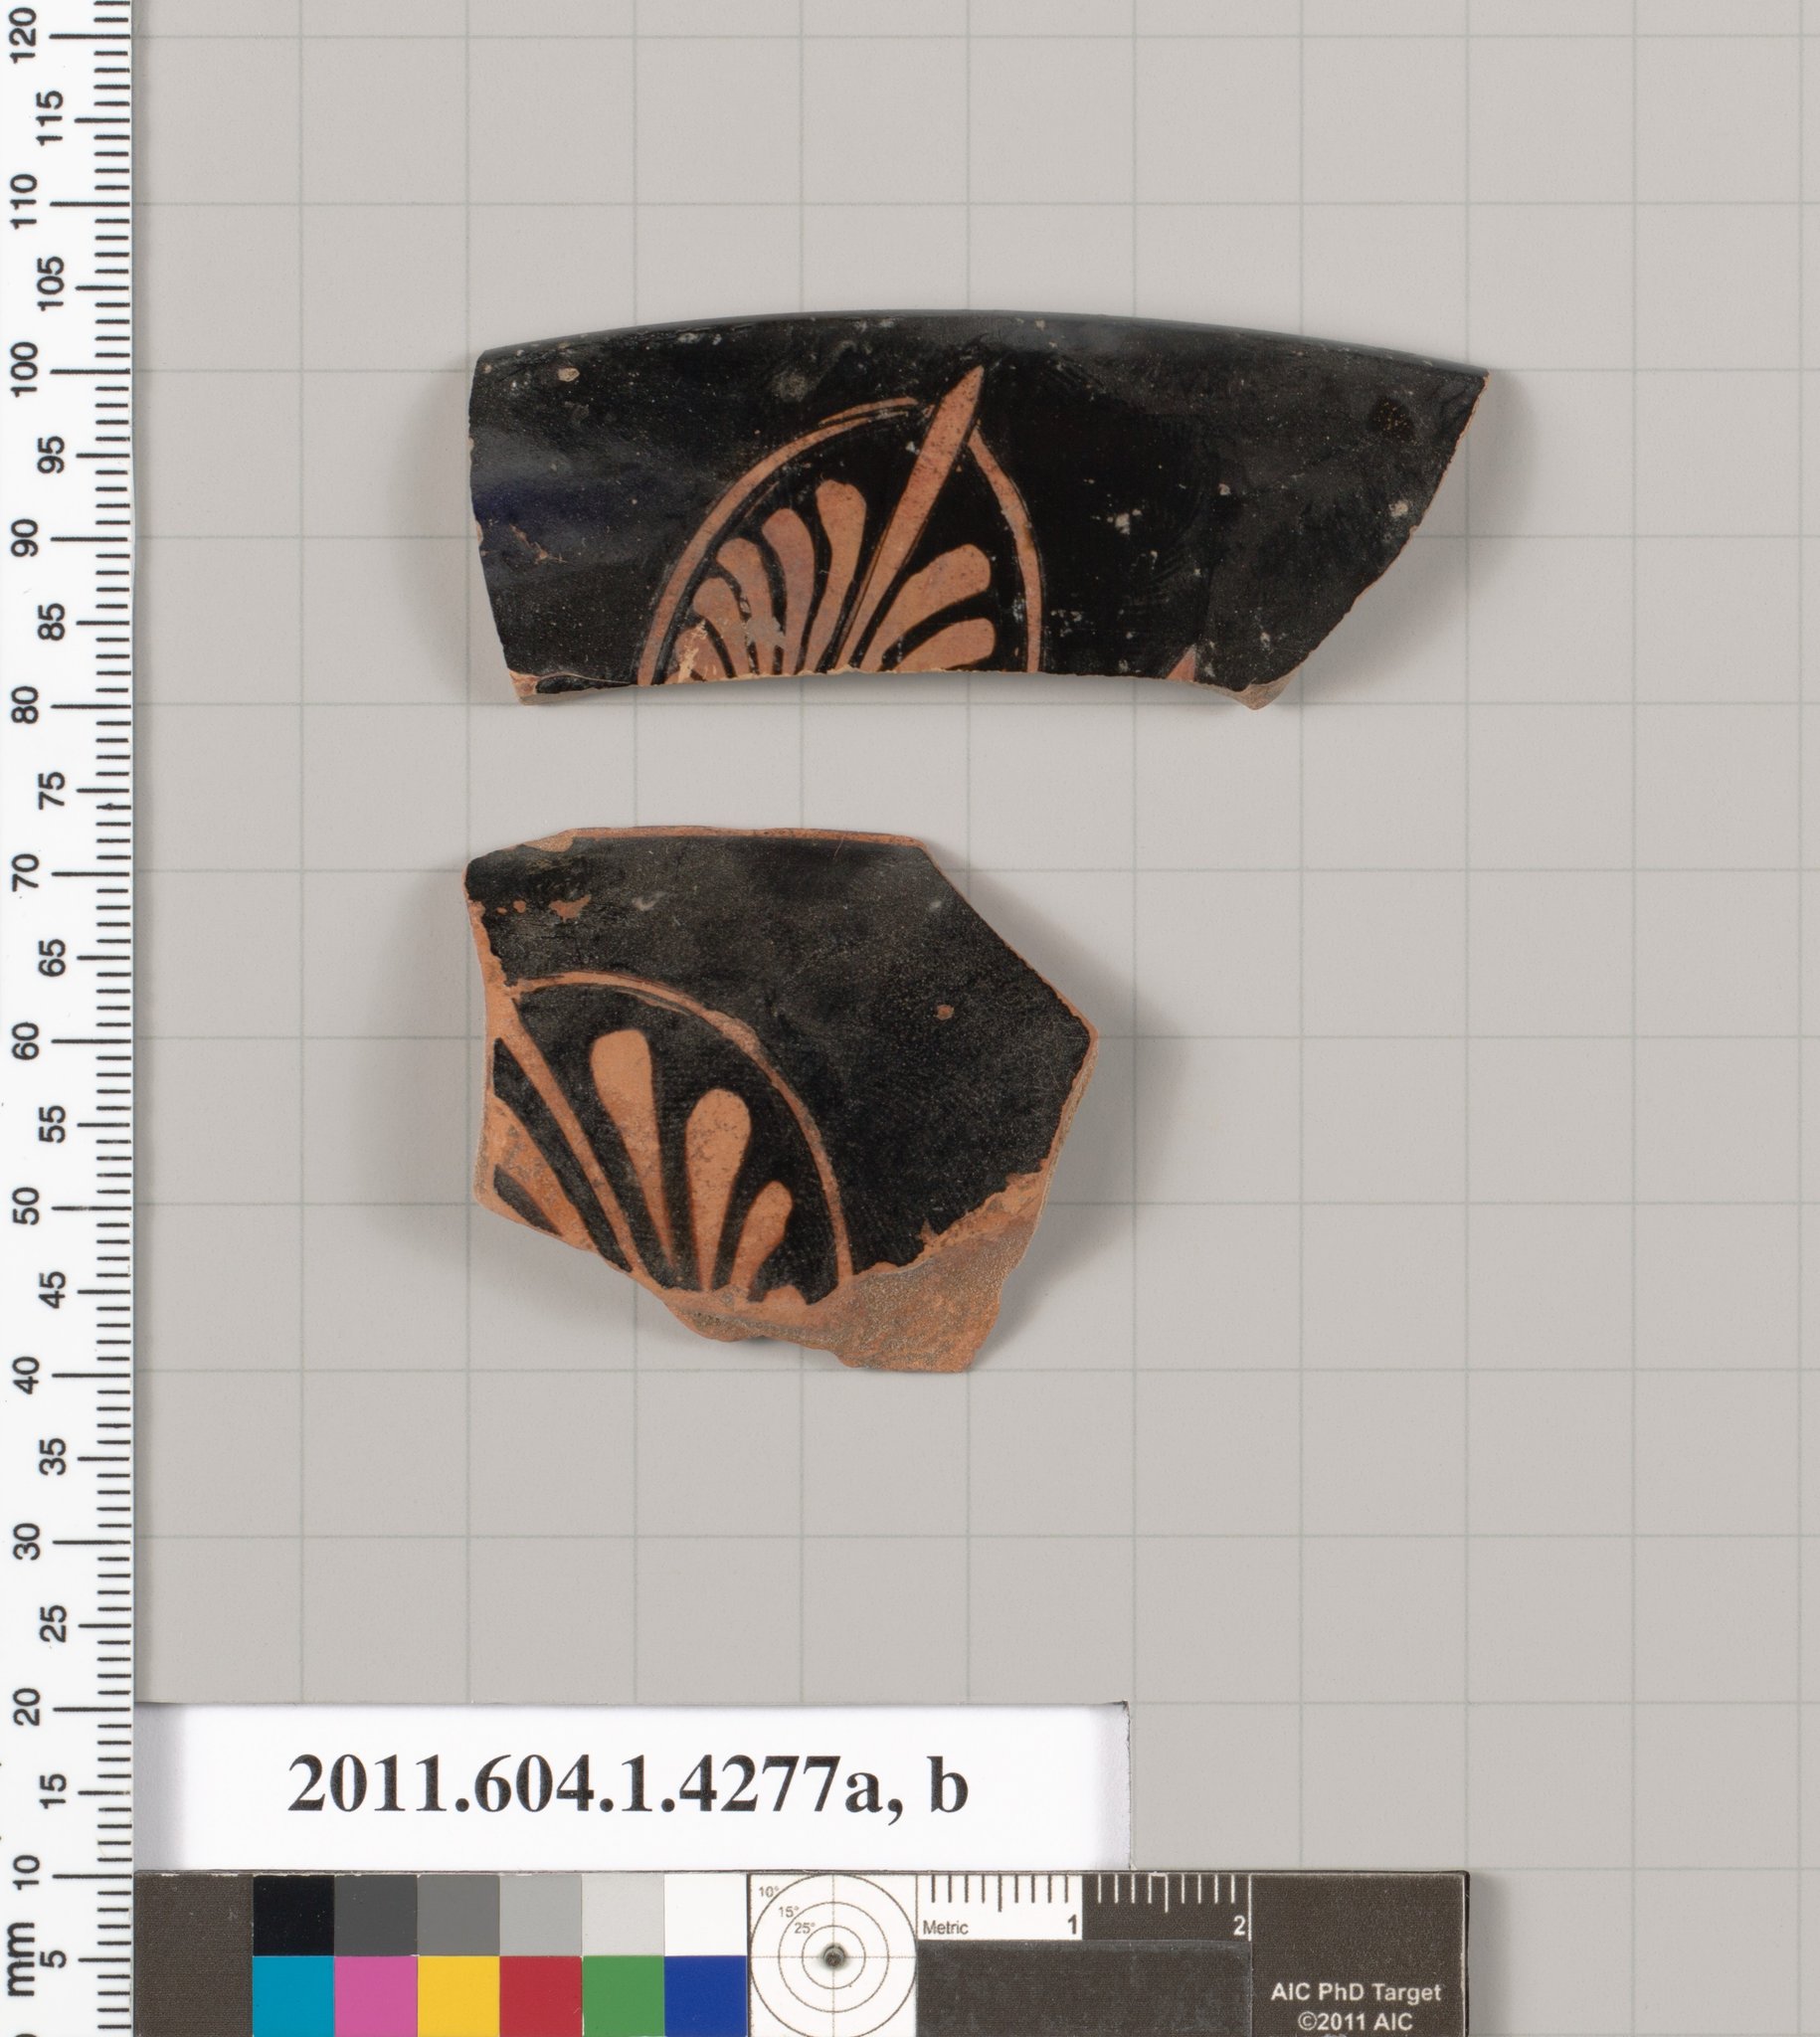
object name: kylix fragment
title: Terracotta rim fragments of kylikes (drinking cups)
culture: greek, attic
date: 475-451 BCE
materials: terracotta